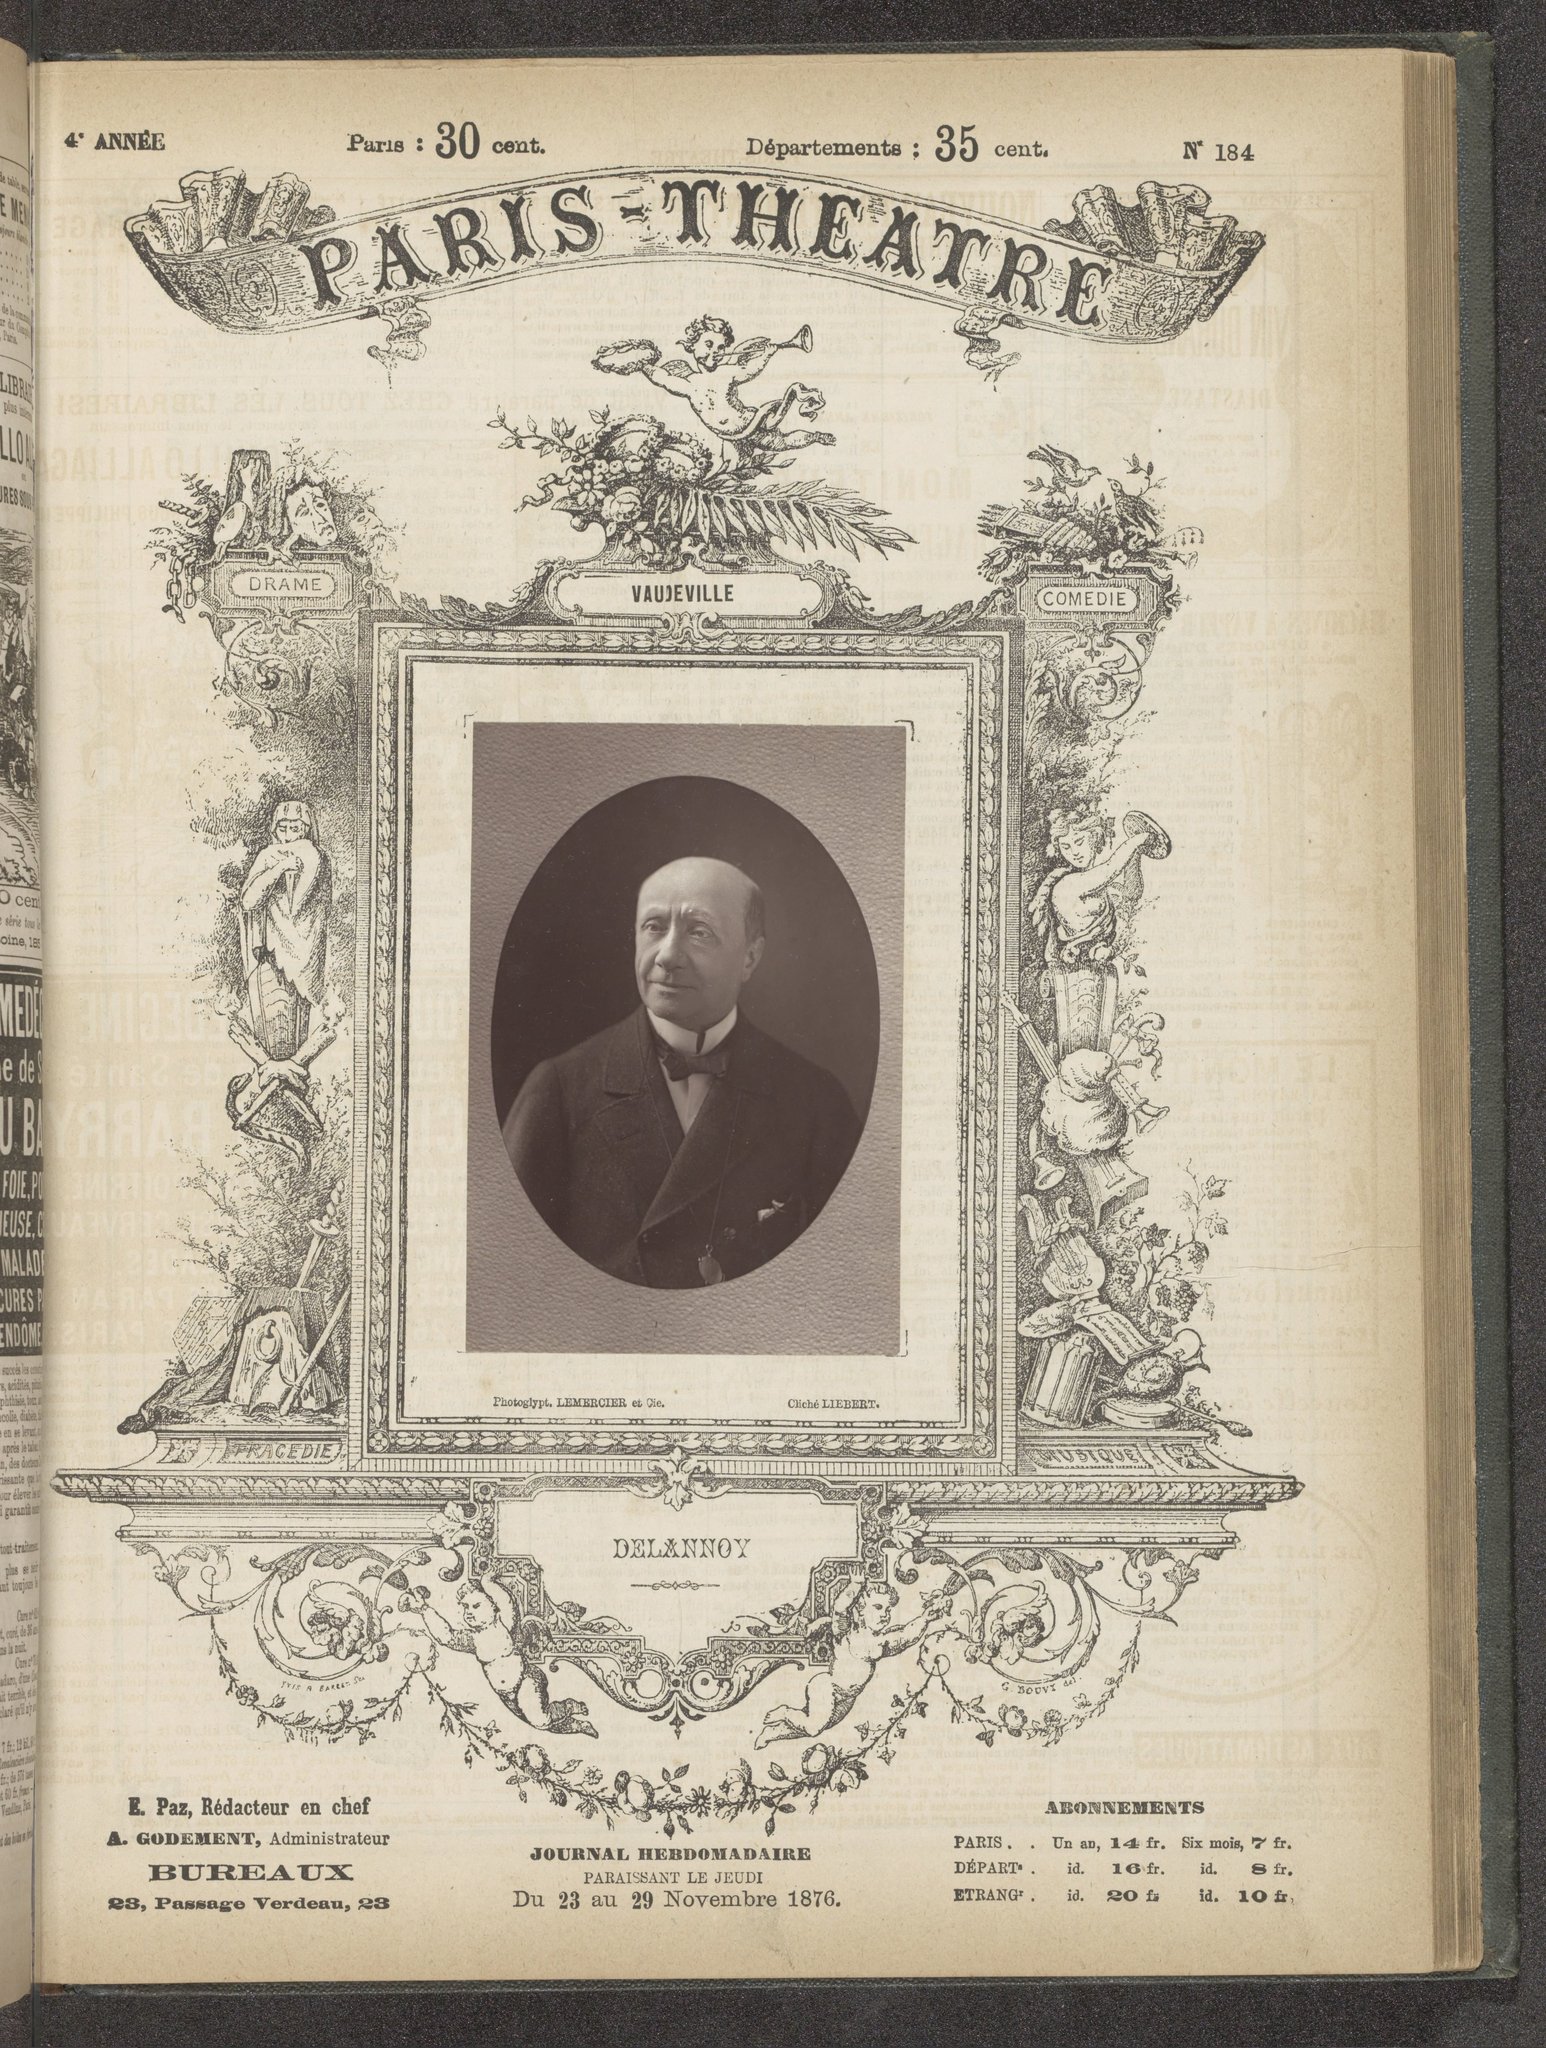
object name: photomechanical print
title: Delannoy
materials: paper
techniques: woodburytype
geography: france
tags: portrait of actor, actress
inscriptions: inscription: ‘Journal hebdomadaire paraissant le jeudi Du 23 au 29 Novembre 1876’, number: ‘N' 184’